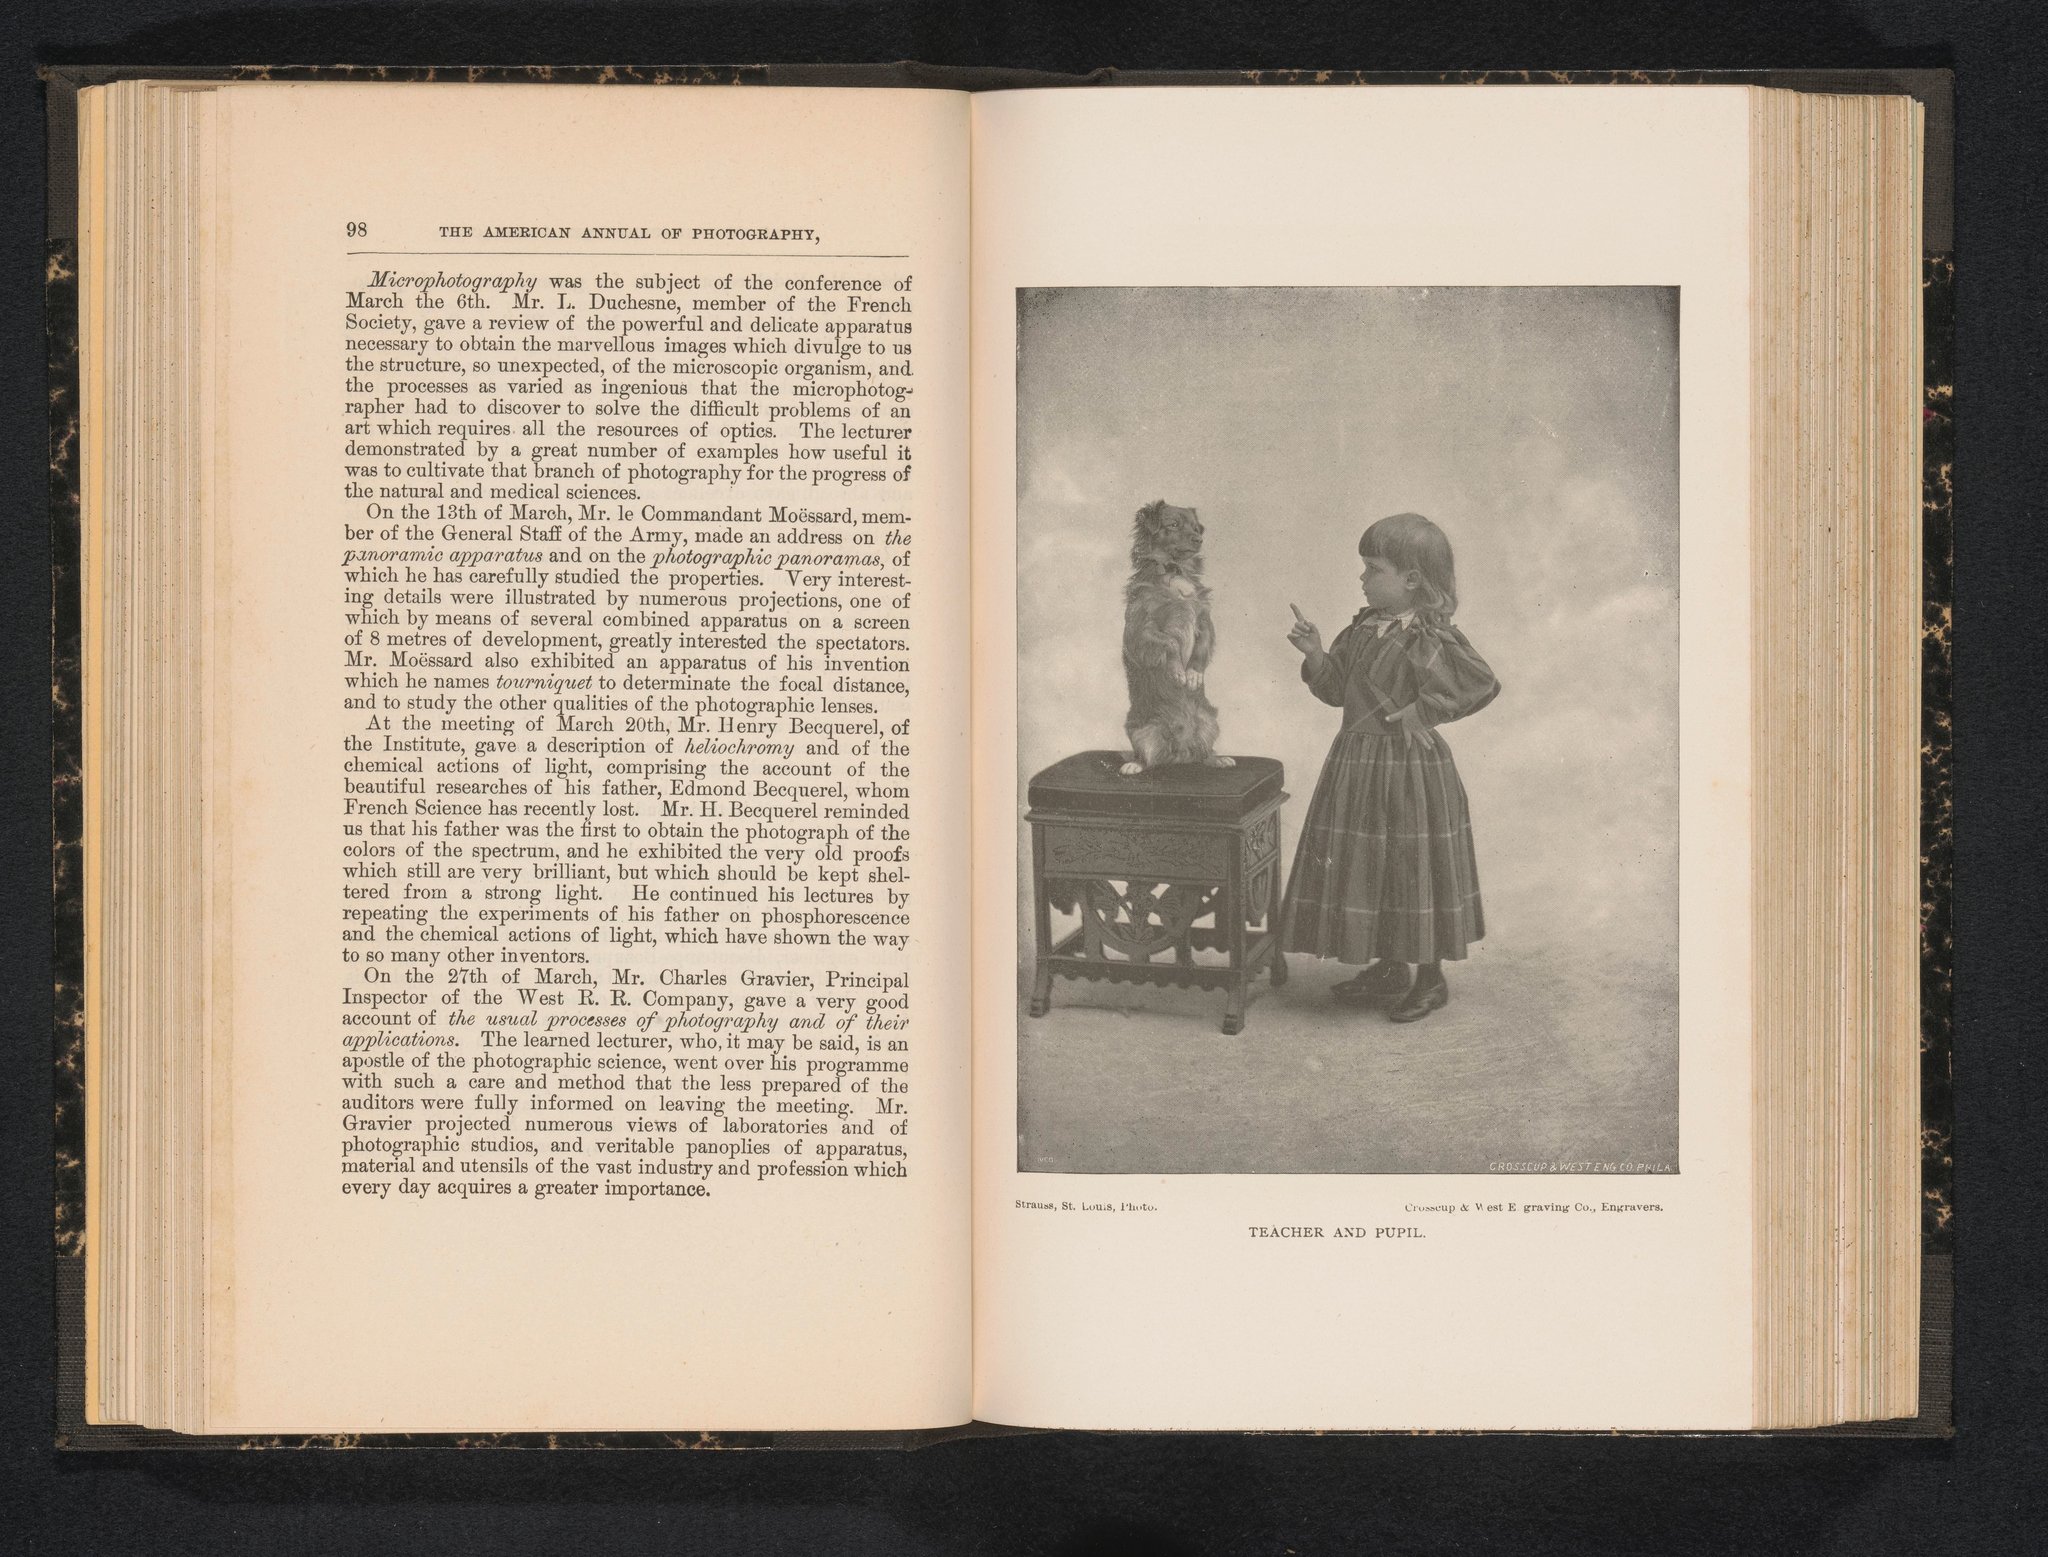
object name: page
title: Portret van een onbekend meisje die de hond een trucje leert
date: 1887-1907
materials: paper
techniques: autotype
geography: philadelphia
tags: girl (child between toddler and youth), training of dogs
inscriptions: inscription: ‘Crosscup & West Eng CO. Phila’